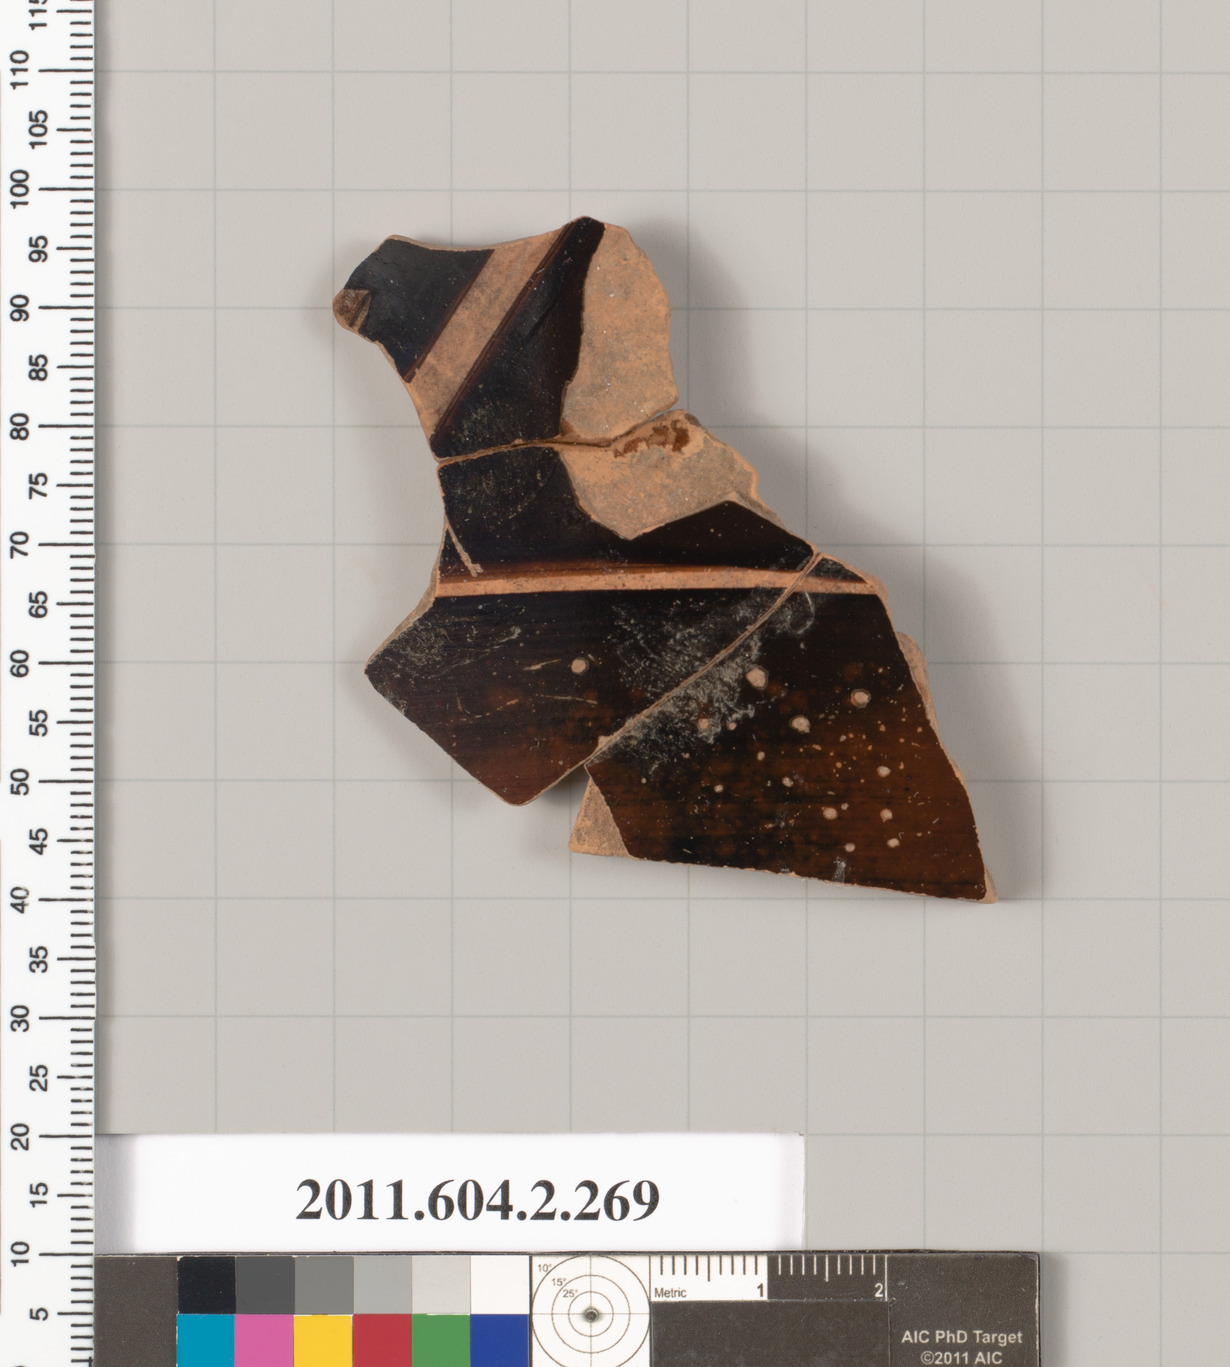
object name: stamnos fragment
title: Terracotta fragment of a stamnos (jar)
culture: greek, attic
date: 490-470 BCE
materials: terracotta